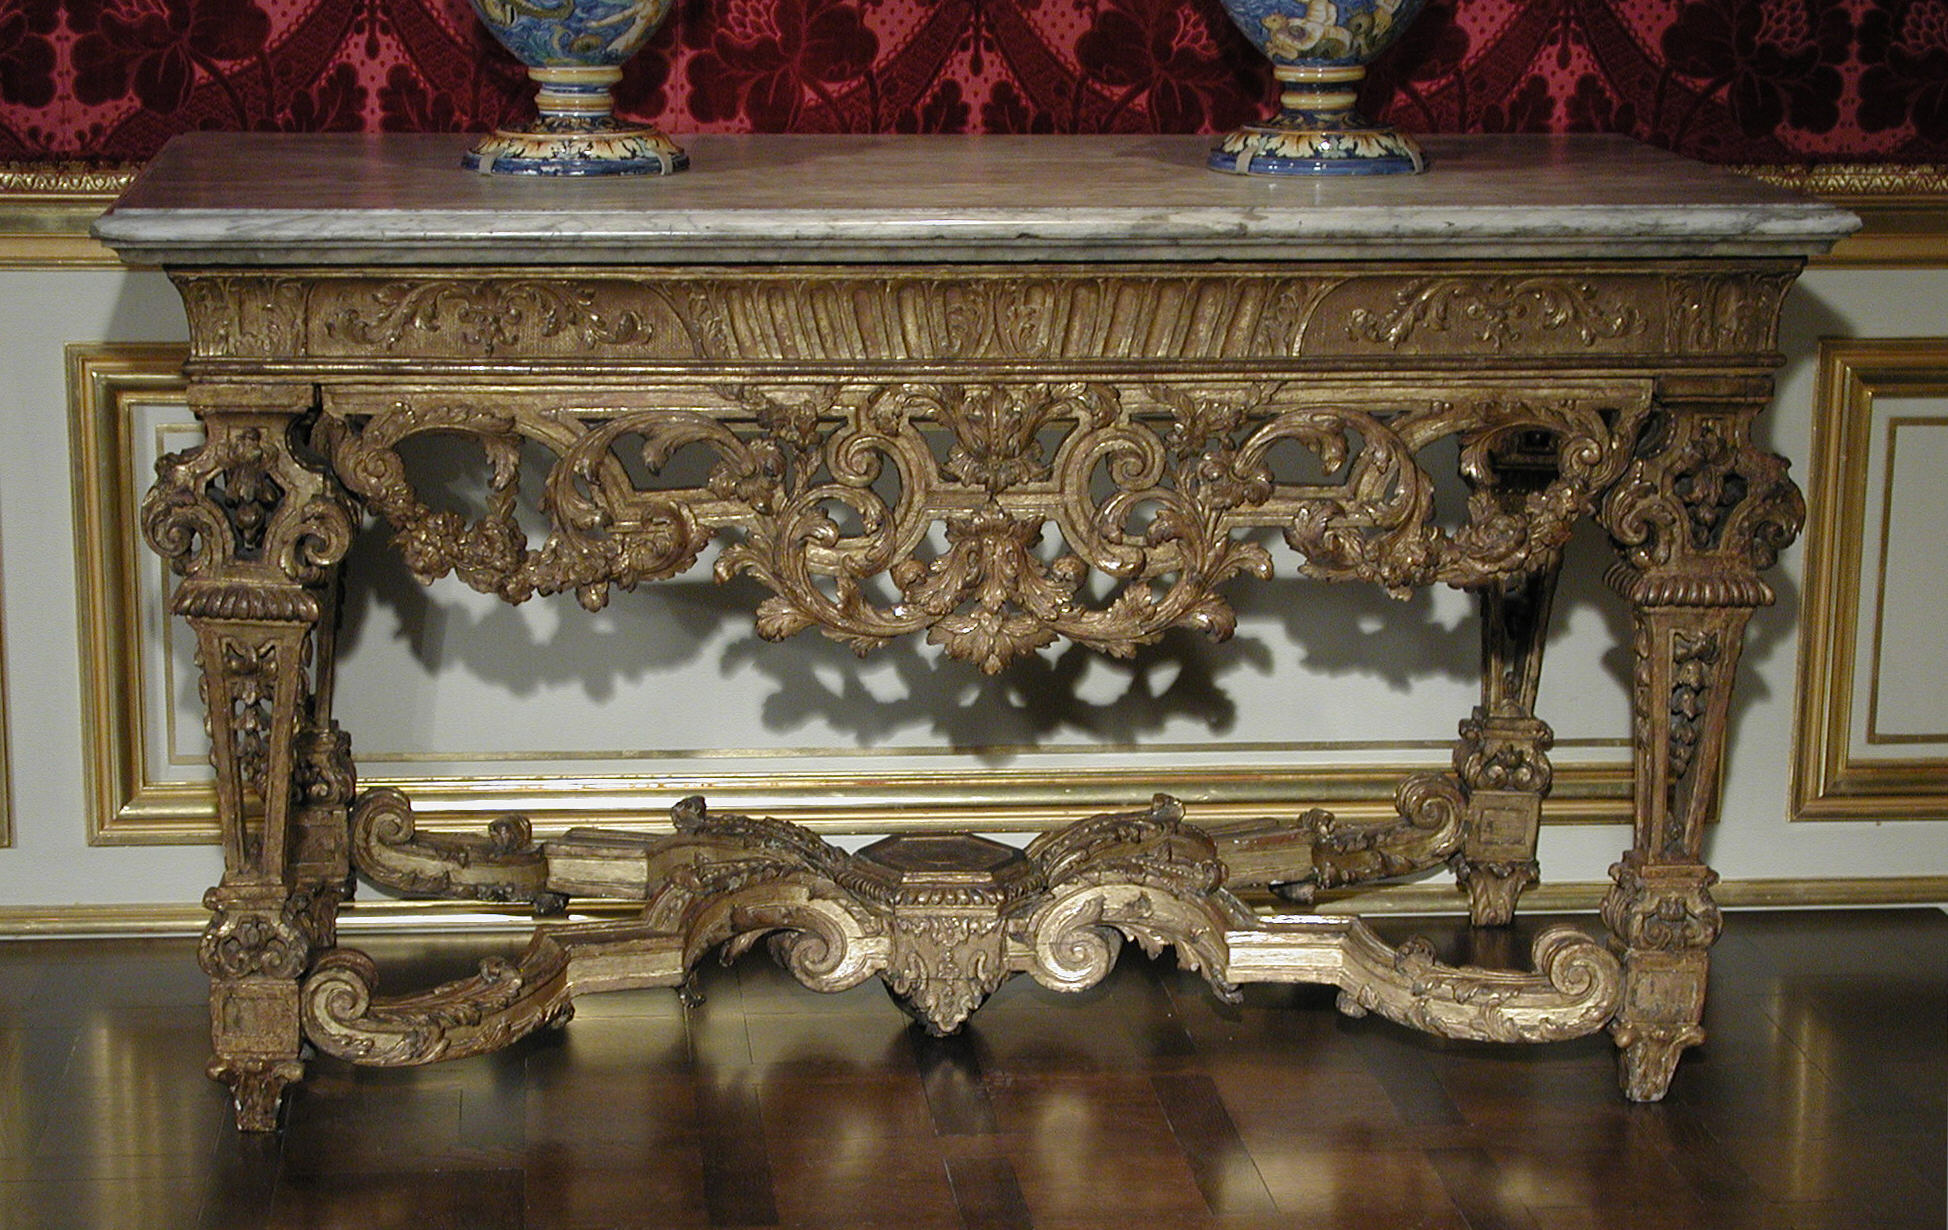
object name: table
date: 1667-1700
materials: marble, wood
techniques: carving, gilding